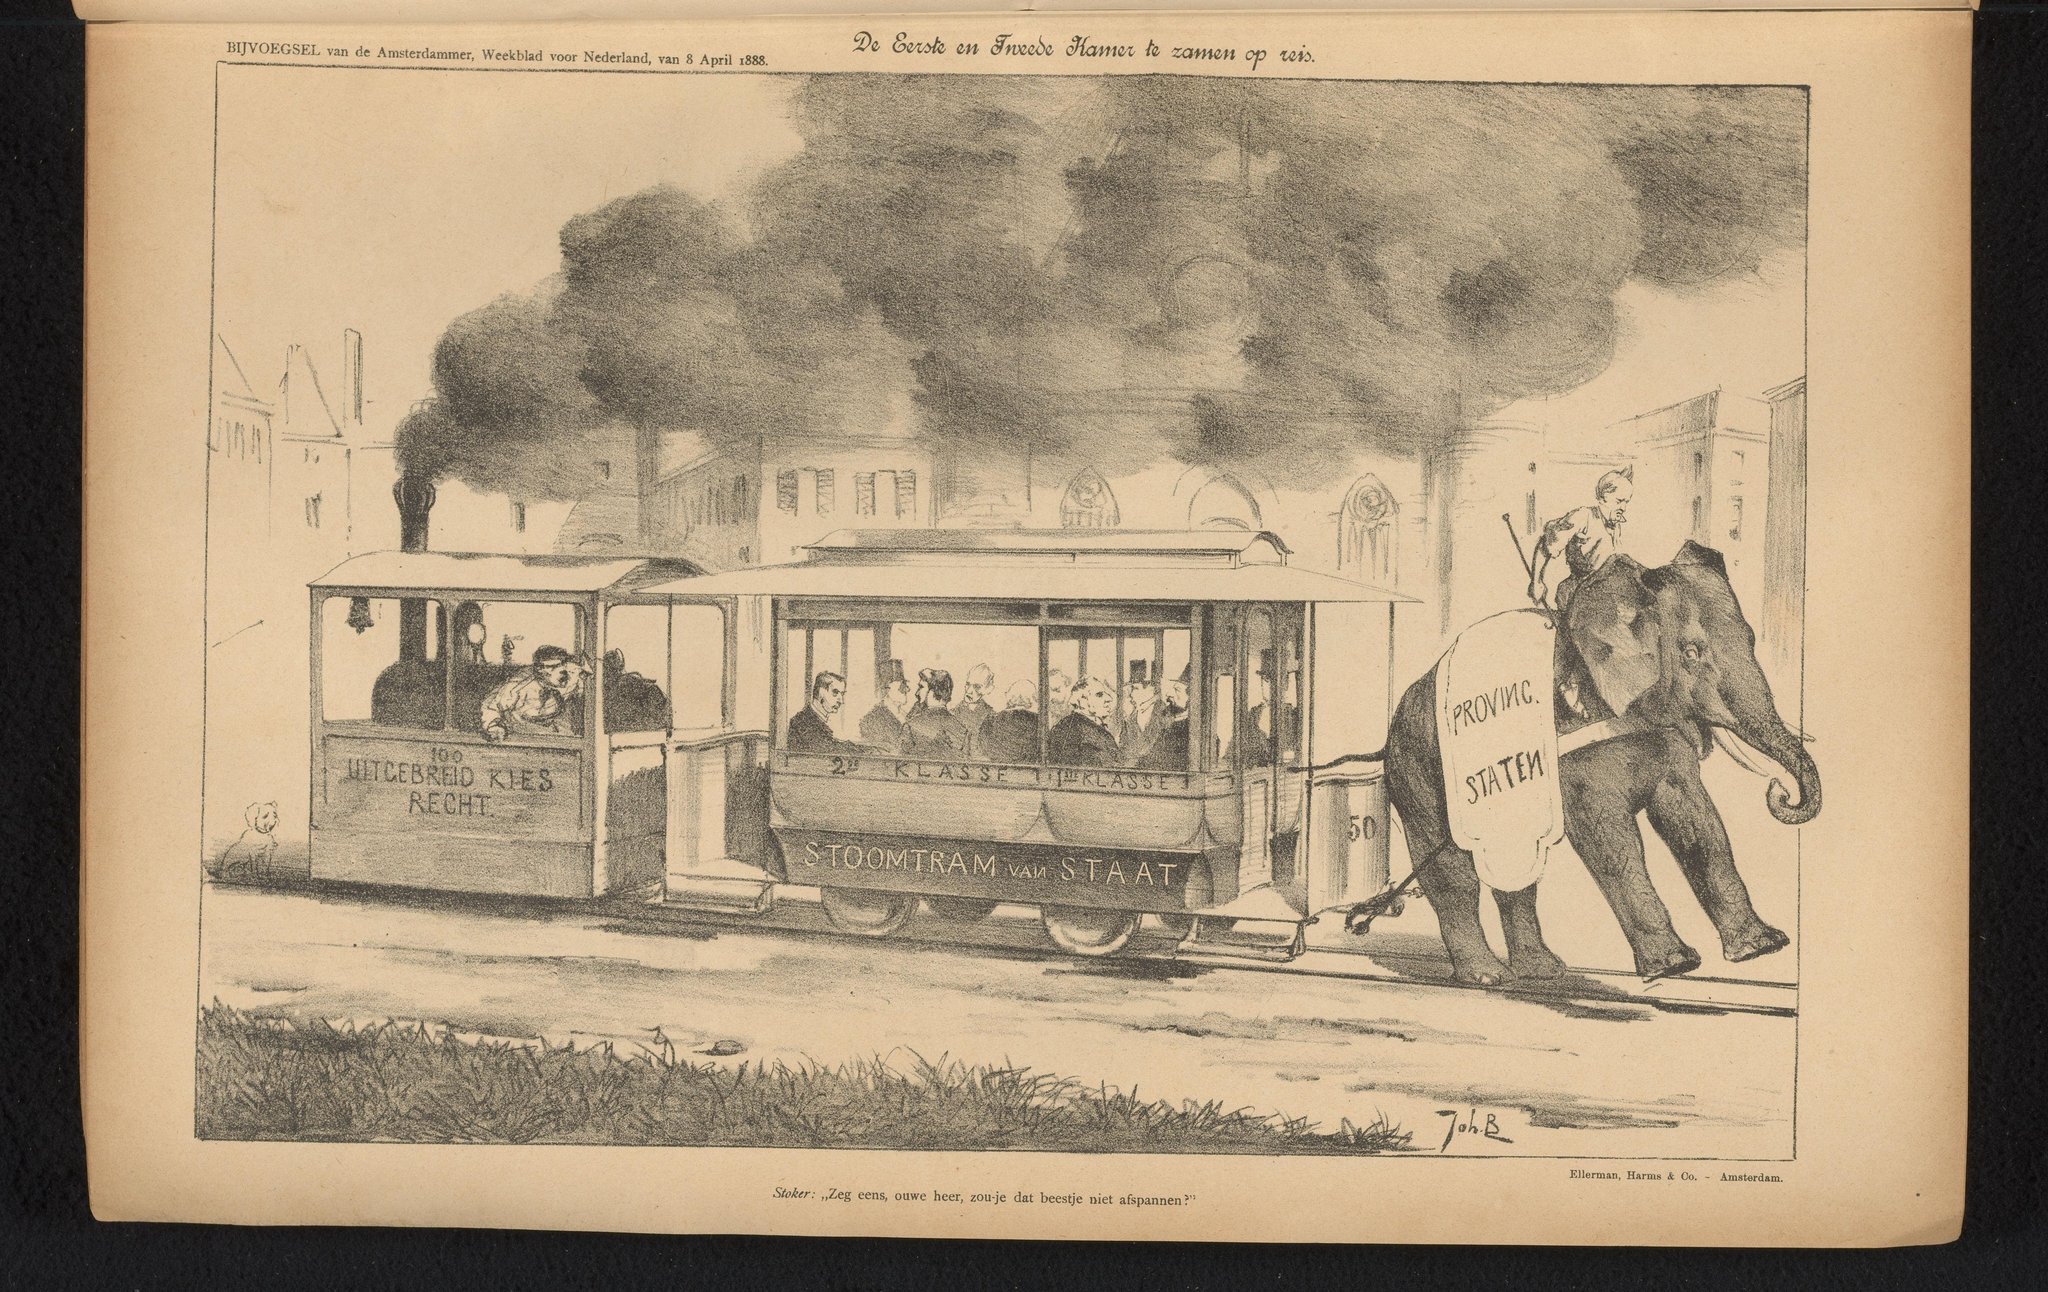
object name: cartoon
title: De Eerste en Tweede Kamer te zamen op reis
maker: johan braakensiek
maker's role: draughtsman, print maker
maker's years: 1858-1940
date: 1888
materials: paper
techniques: lithograph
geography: amsterdam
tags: amsterdam, the hague, politician, tram, the right to vote, the compulsory vote, steam locomotive, trunked animals: elephant, political caricatures and satires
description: Leden van de Eerste en Tweede Kamer samen op reis in de 'Stoomtram van Staat' getrokken door de locomotief 'Uitgebreid Kiesrecht'. De machinist van de tram vraagt of de olifant van de Provinciale Staten, die de vooruitgang van tram tegenhoudt, niet losgekoppeld kan worden. Op de olifant zit Jan Heemskerk.